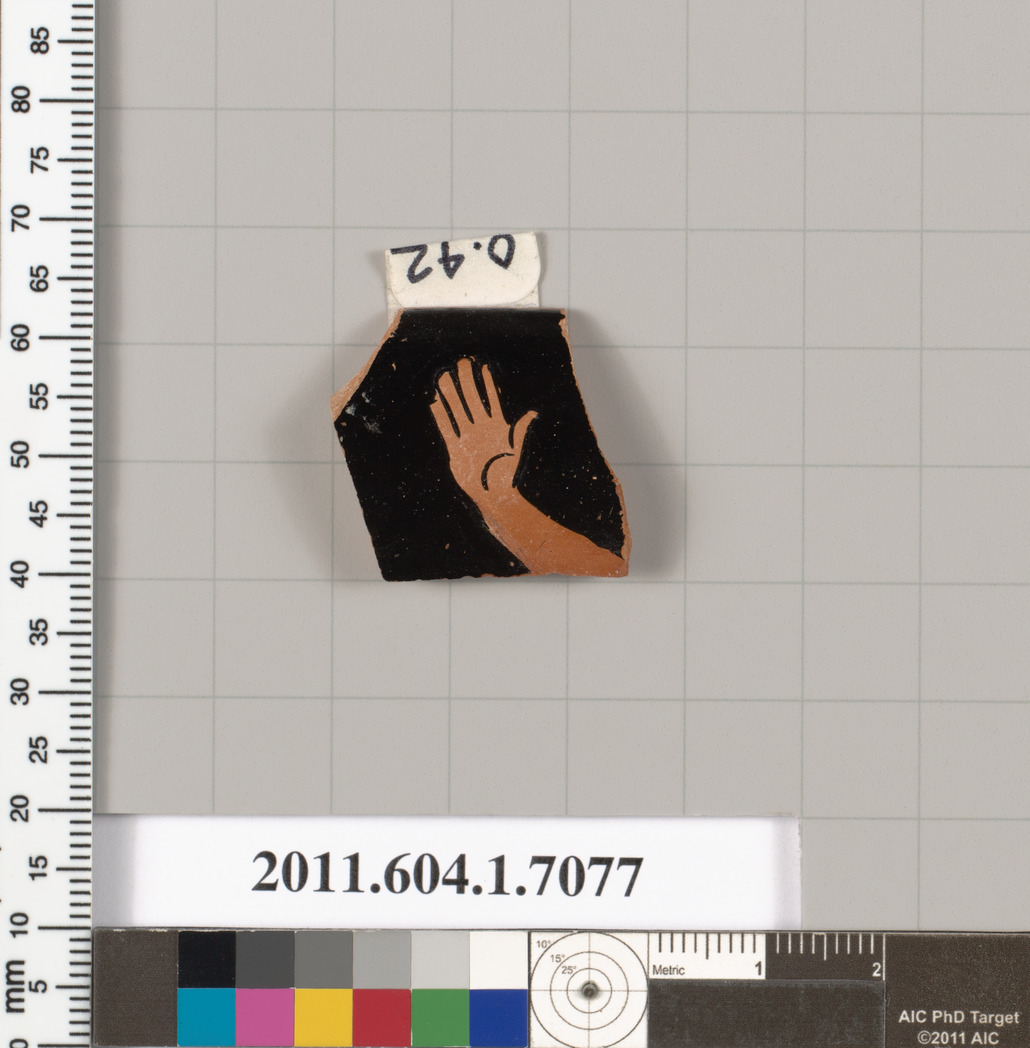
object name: kylix fragment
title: Terracotta rim fragment of a kylix (drinking cup)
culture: greek, attic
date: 500-480 BCE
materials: terracotta